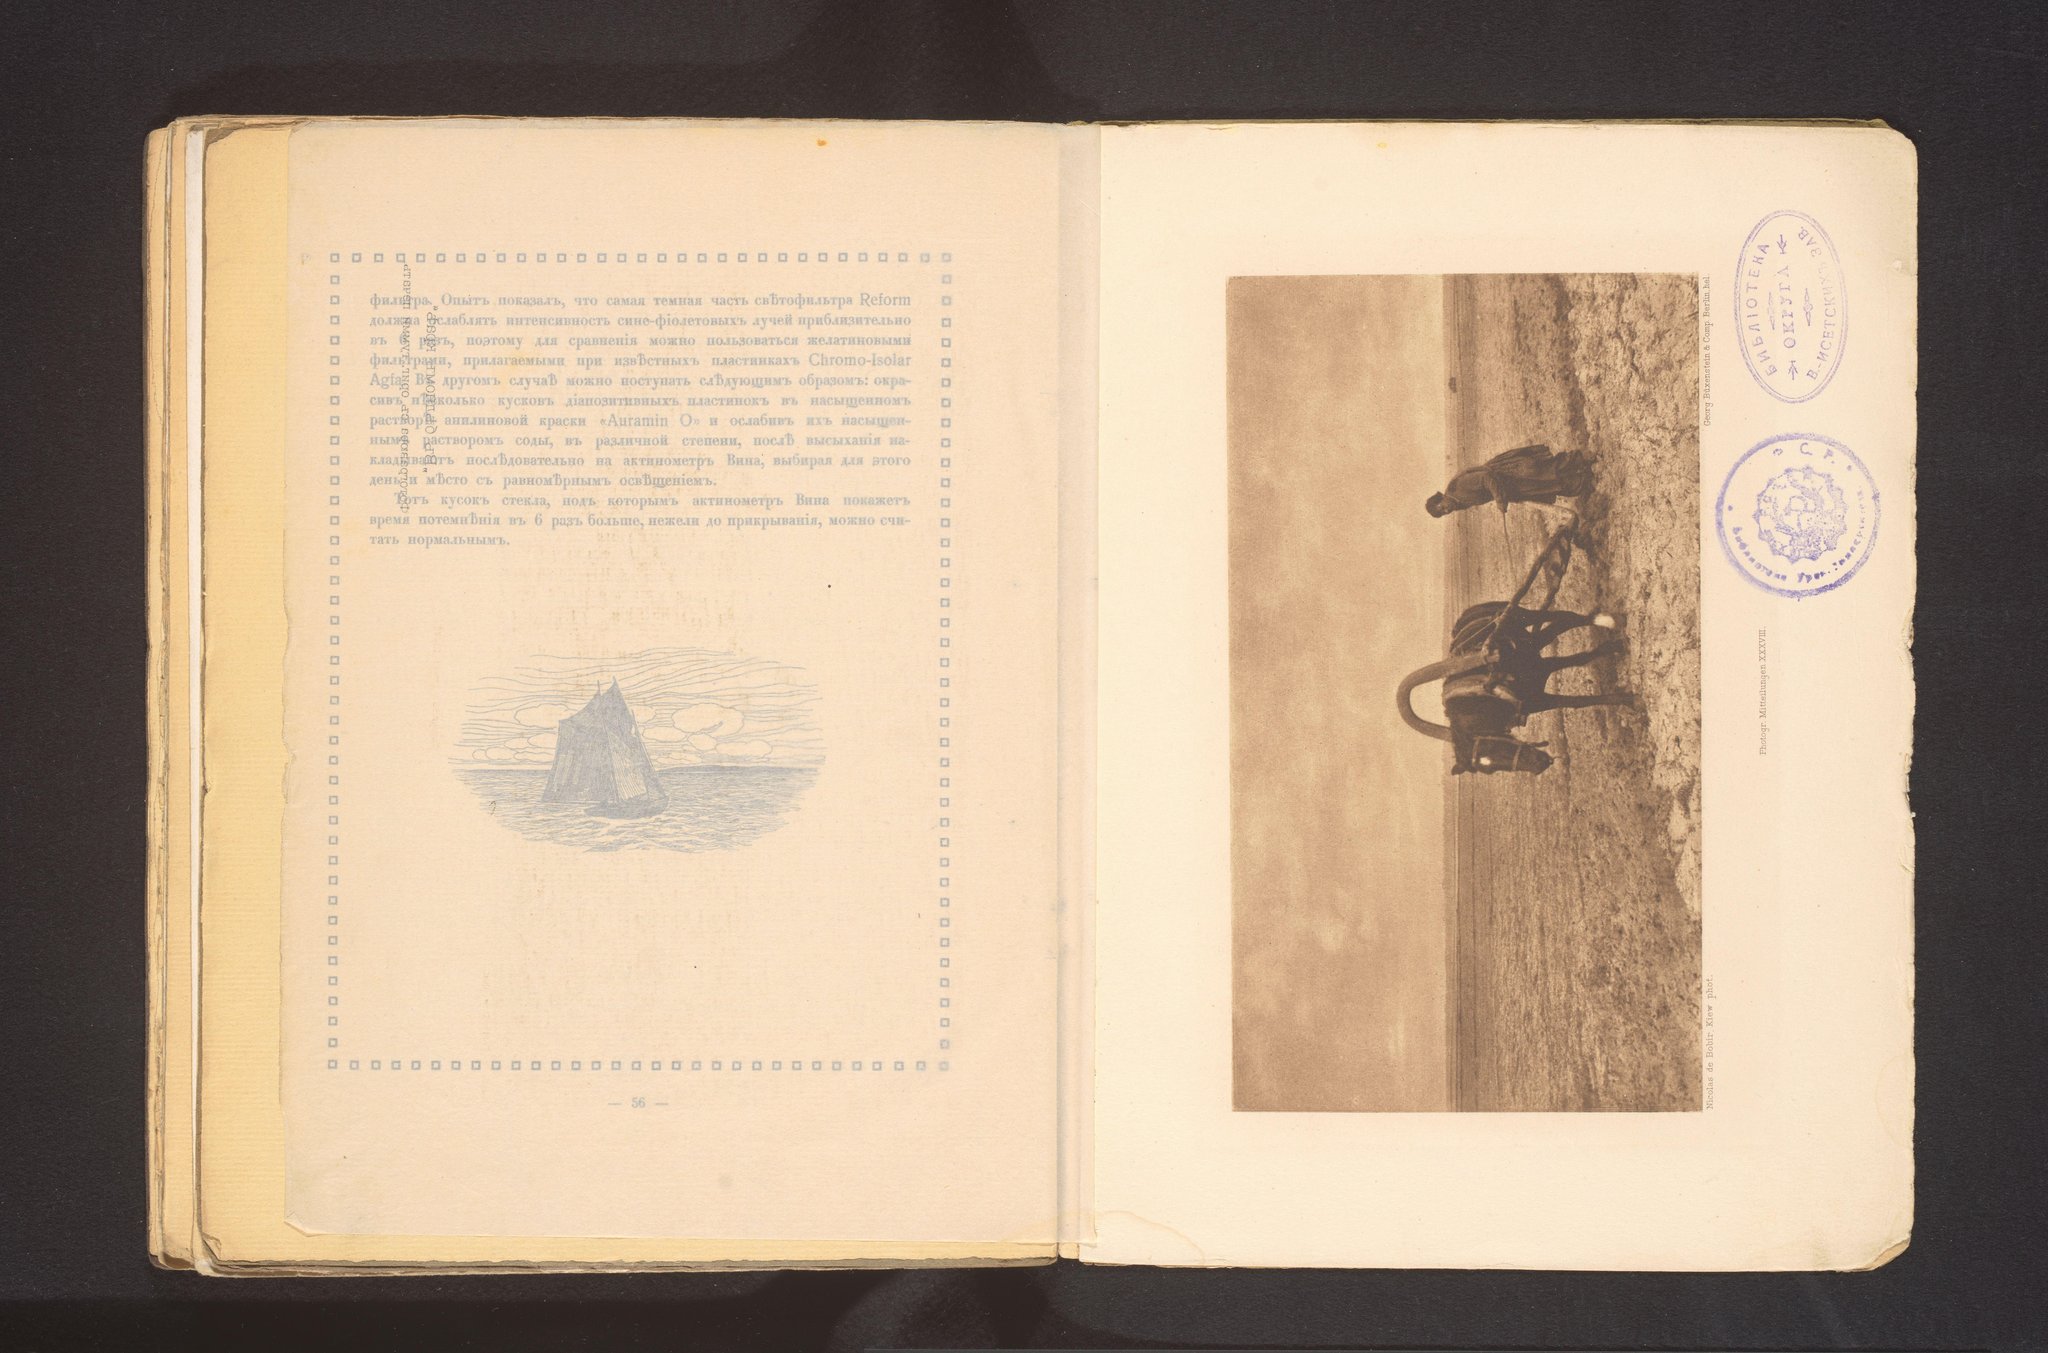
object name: photomechanical print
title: Boer met een ploegpaard in een weiland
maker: nicolas de bobir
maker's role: fotograaf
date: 1897-1907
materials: paper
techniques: photoaquatint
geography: kyiv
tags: farmers, horse, ploughing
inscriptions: inscription